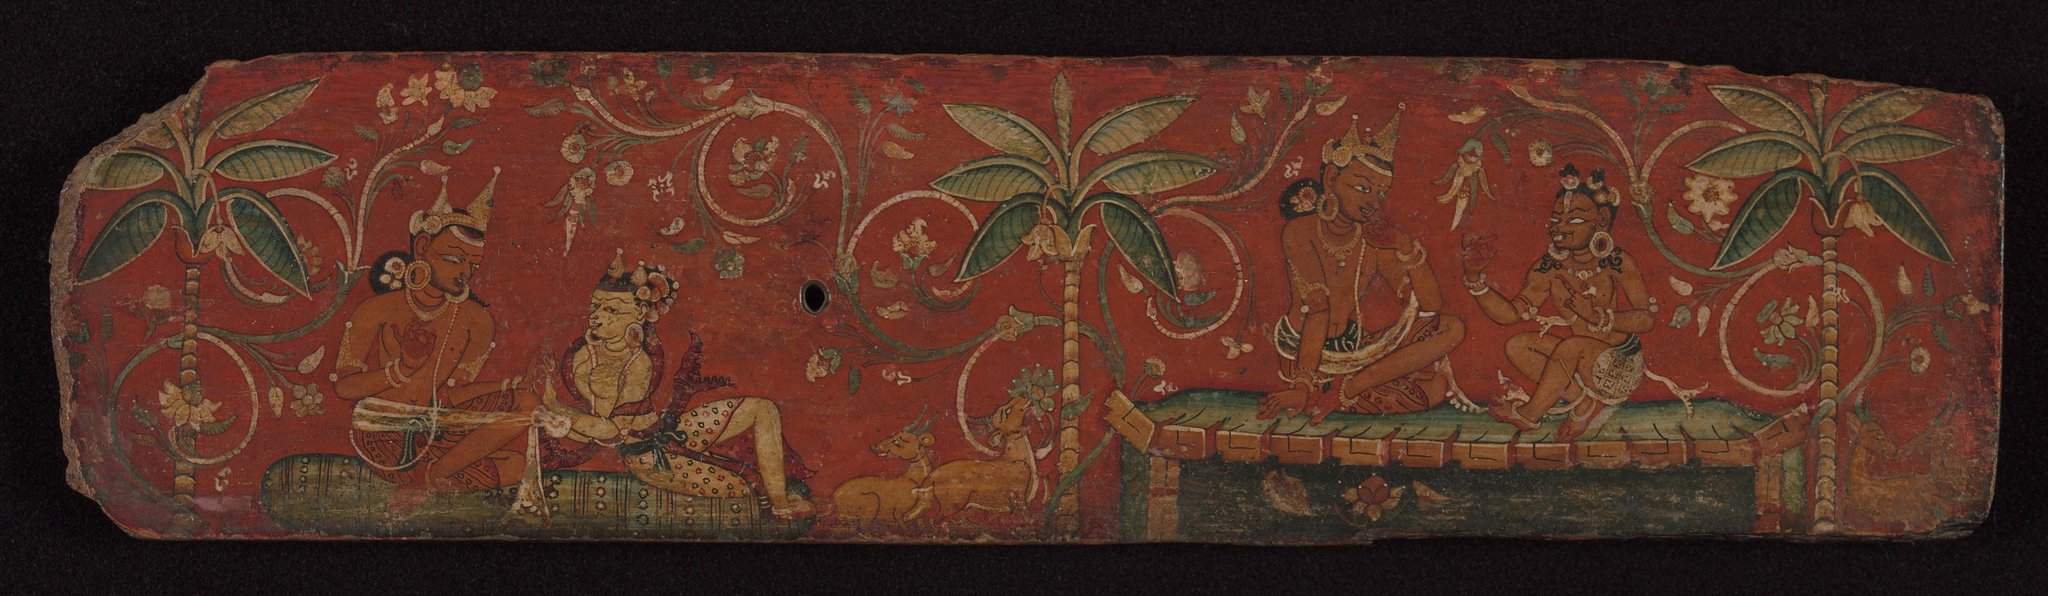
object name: manuscript cover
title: Book cover illustrated with scenes from Kalidasa’s Shakuntala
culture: nepali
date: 1101-1200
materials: ink, wood